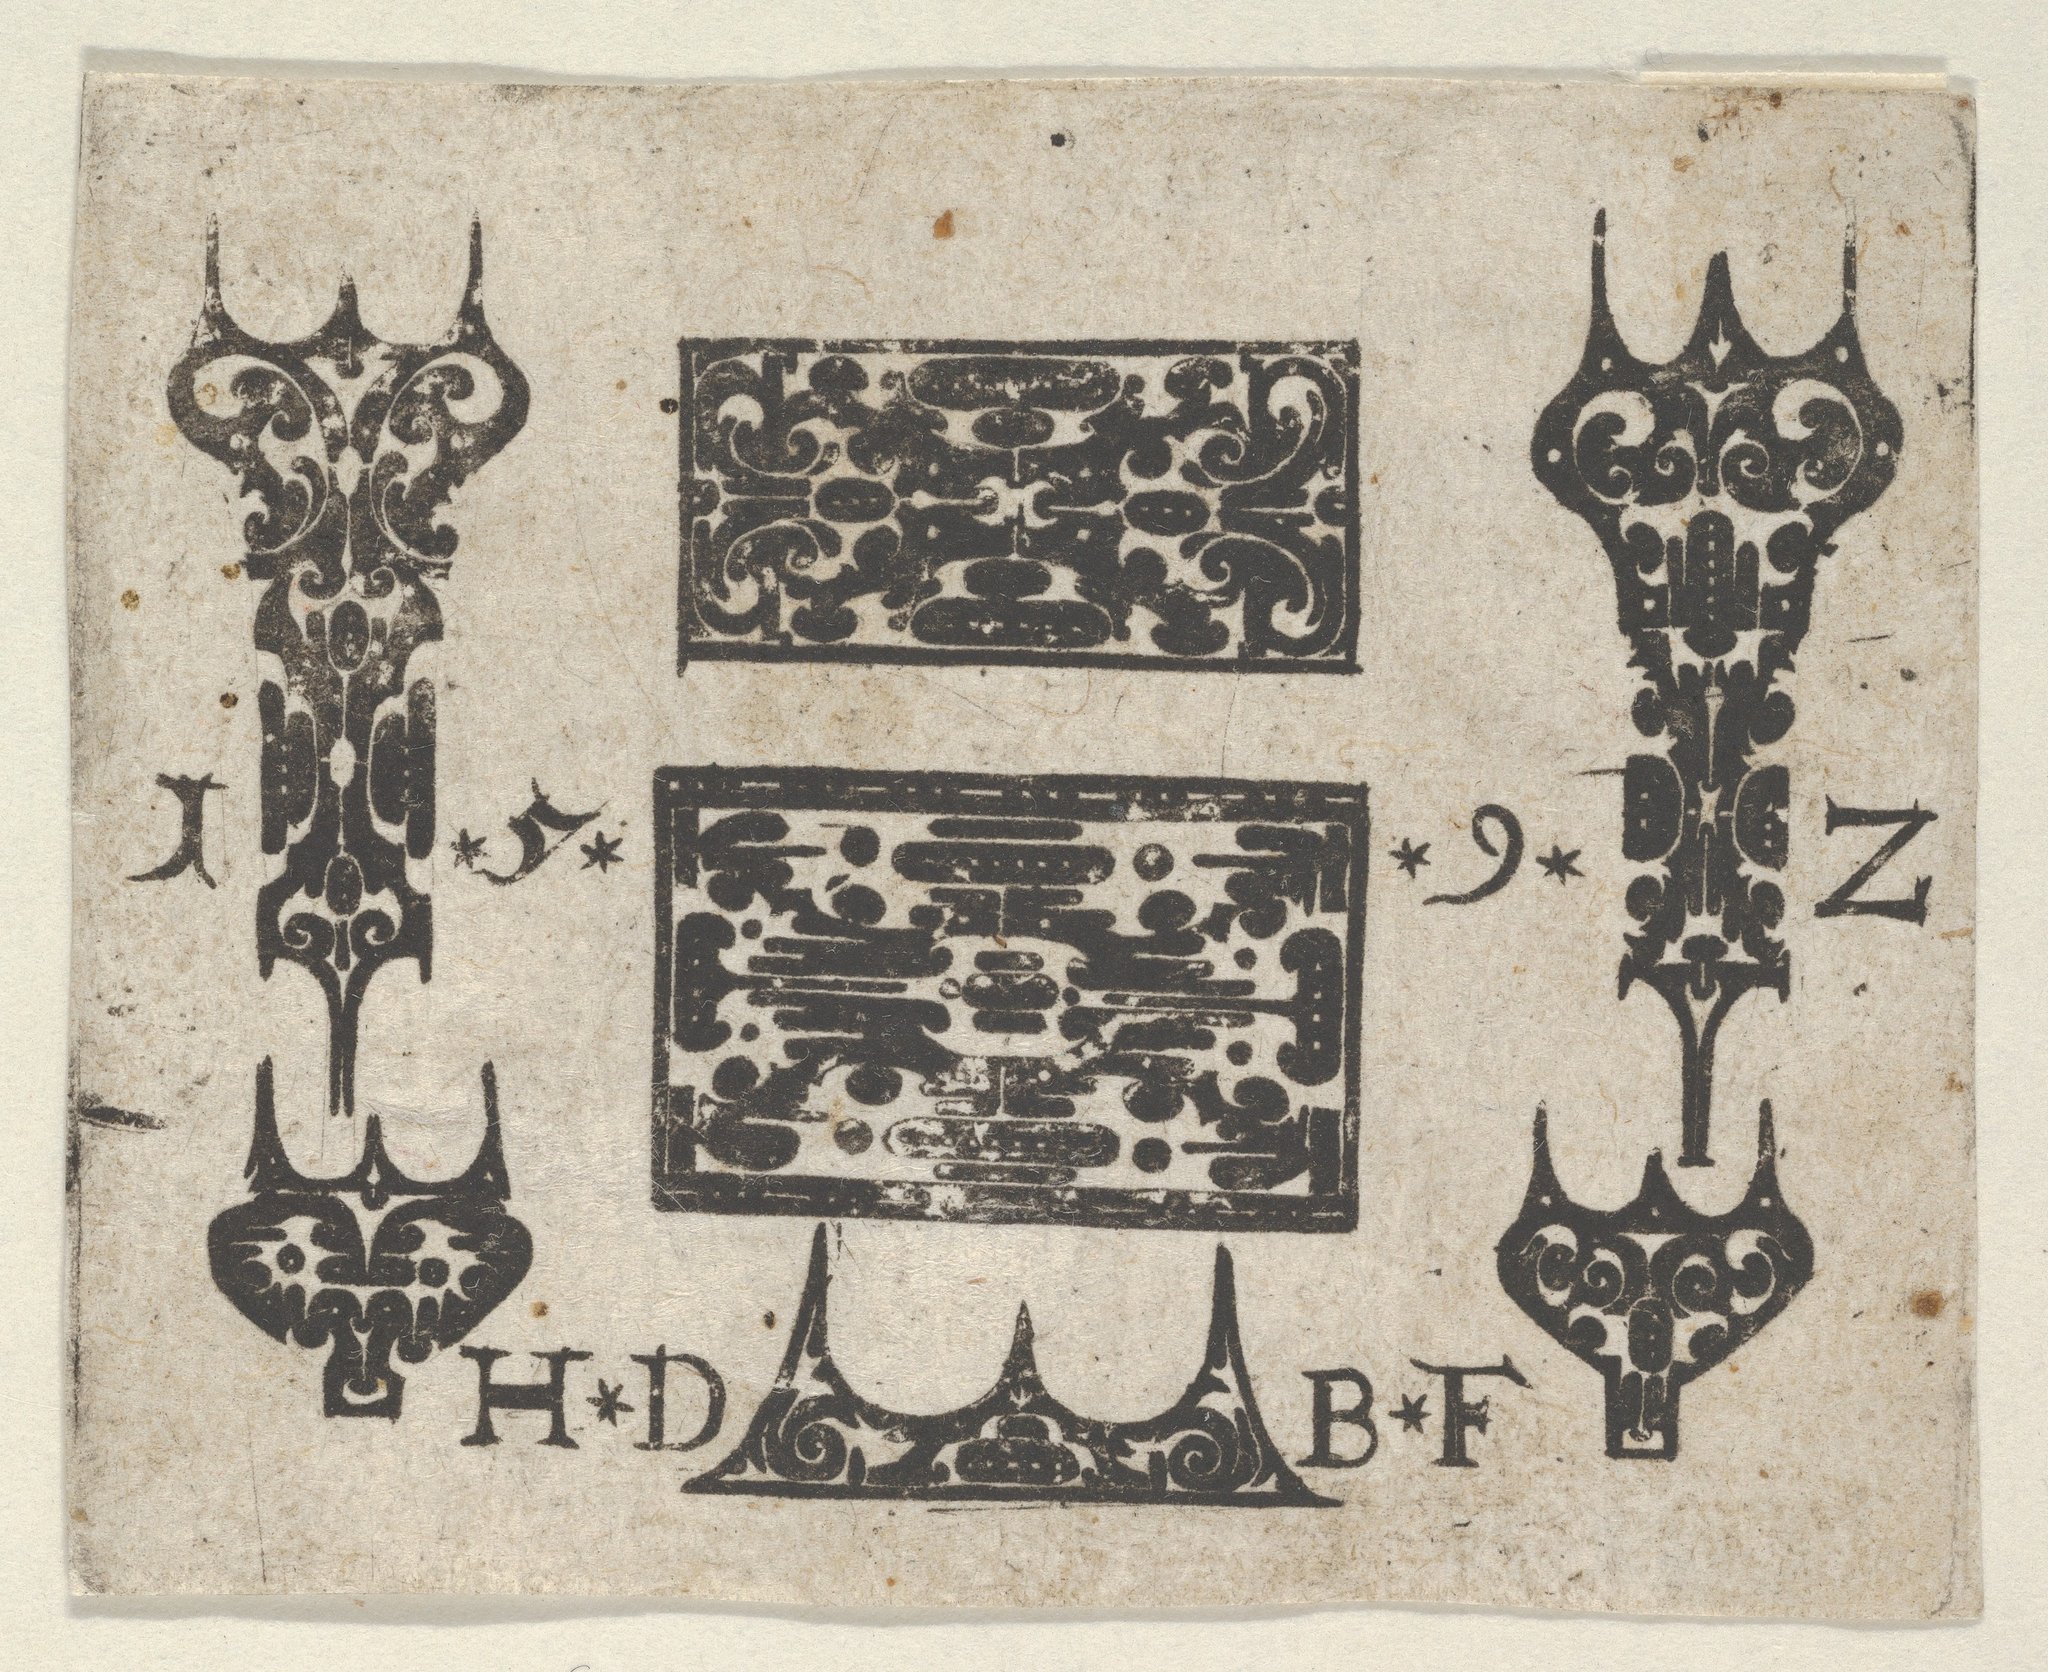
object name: print ornament architecture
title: Blackwork Print with Two Horizontal Panels and Five Small Motifs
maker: hans de bull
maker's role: artist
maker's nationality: german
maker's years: 1592-1604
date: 1592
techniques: embroidery, engraving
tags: ornament